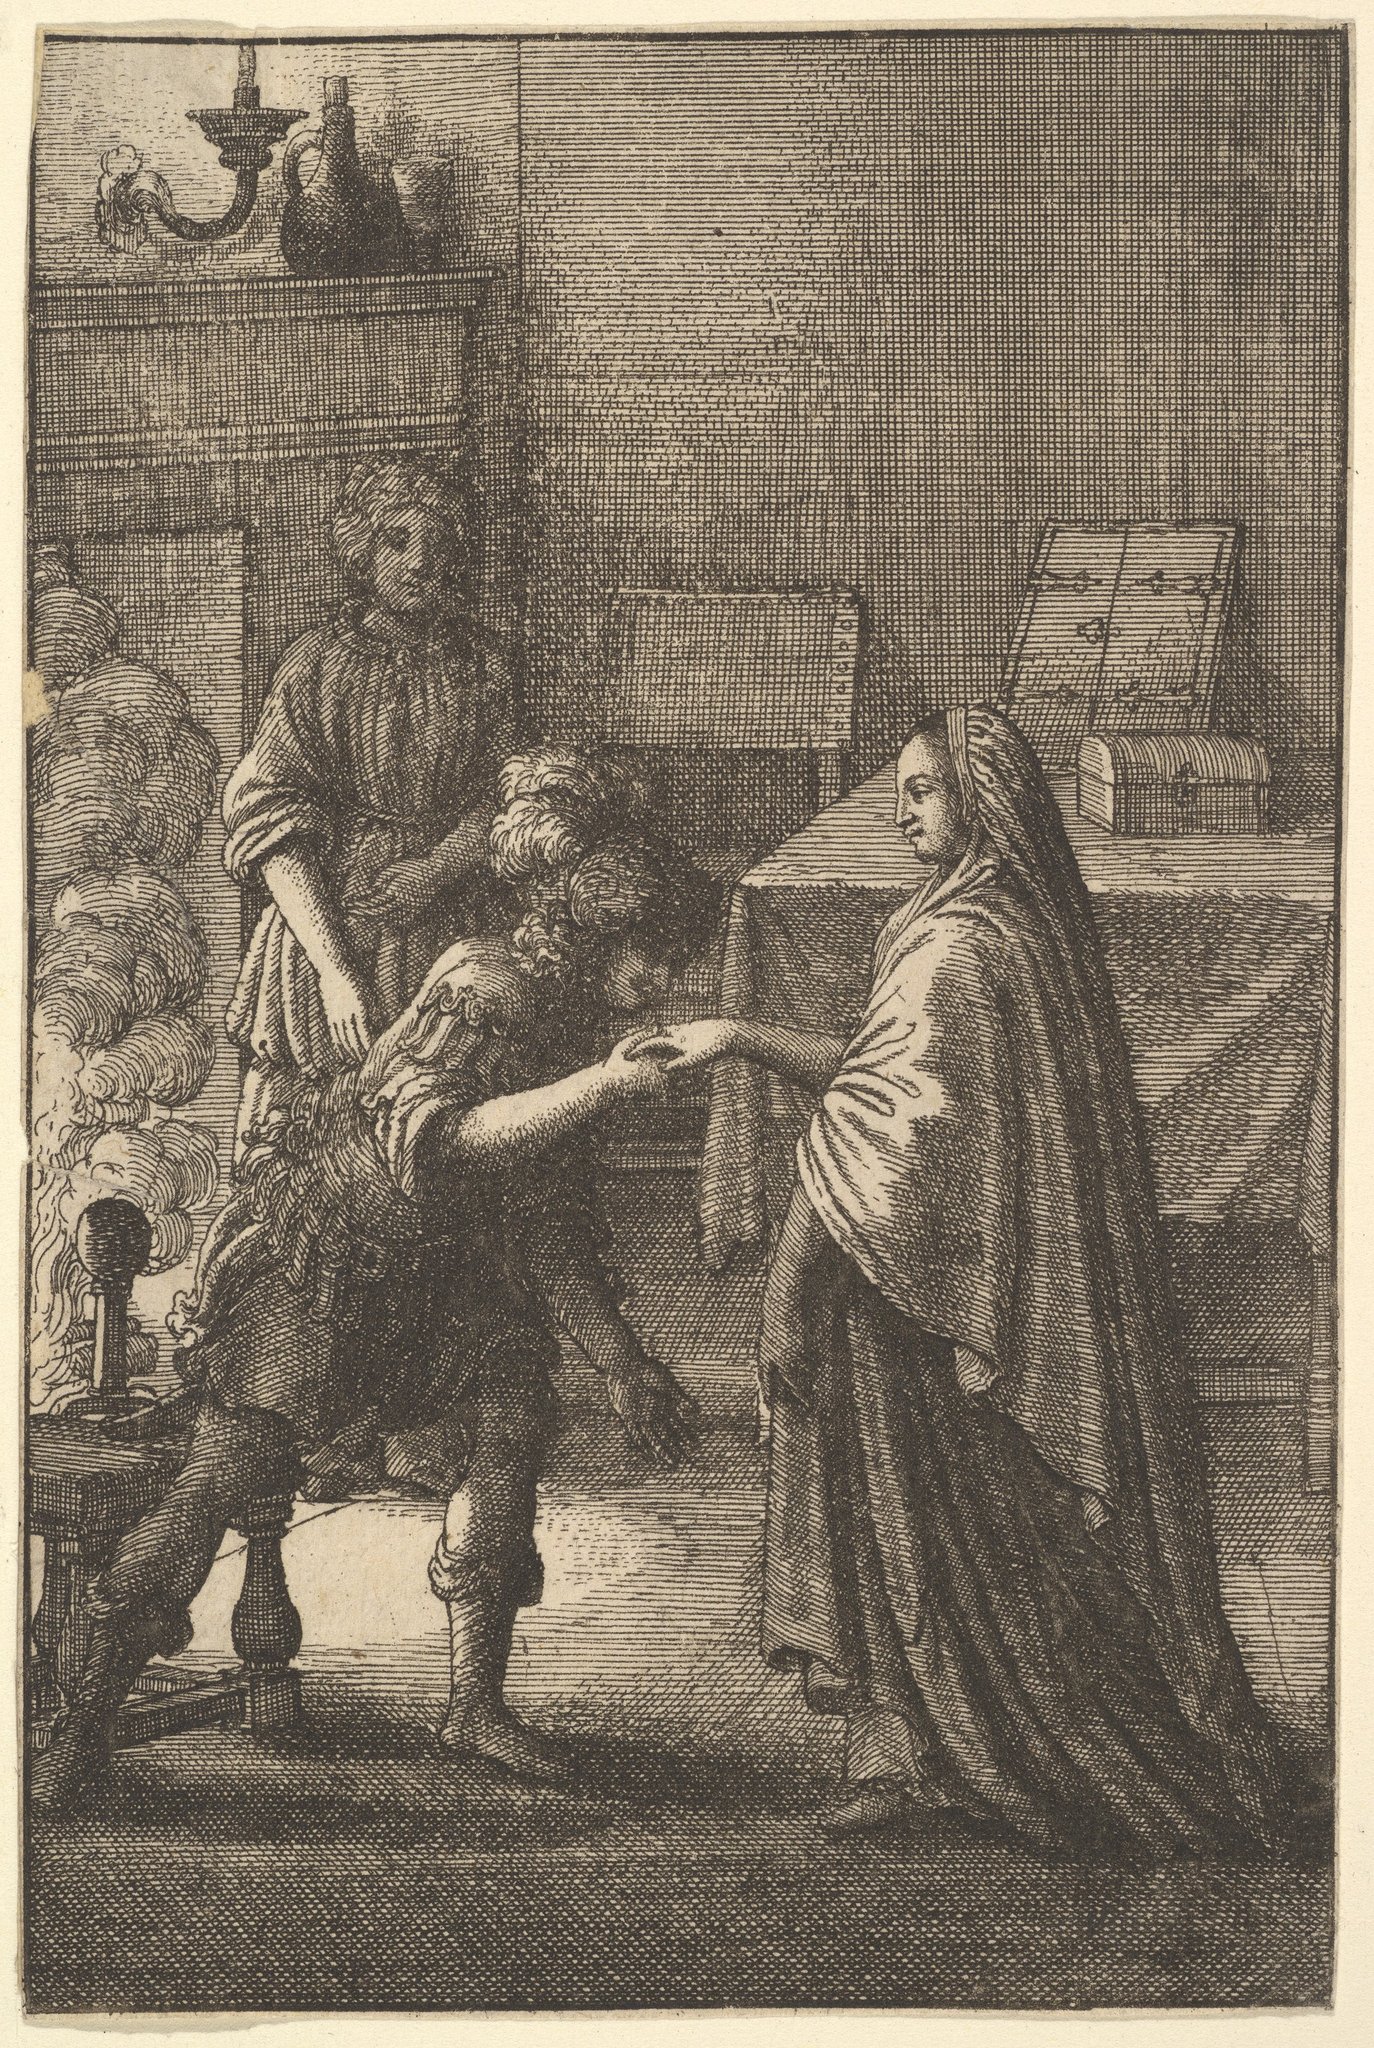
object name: print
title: The soldier kissing the woman's hand (from John Ogilby, "Aesopics or a Second Colllection of Fables," 1668)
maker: wenceslaus hollar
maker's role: artist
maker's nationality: bohemian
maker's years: 1607-1677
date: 1666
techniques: etching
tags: soldiers,men,women